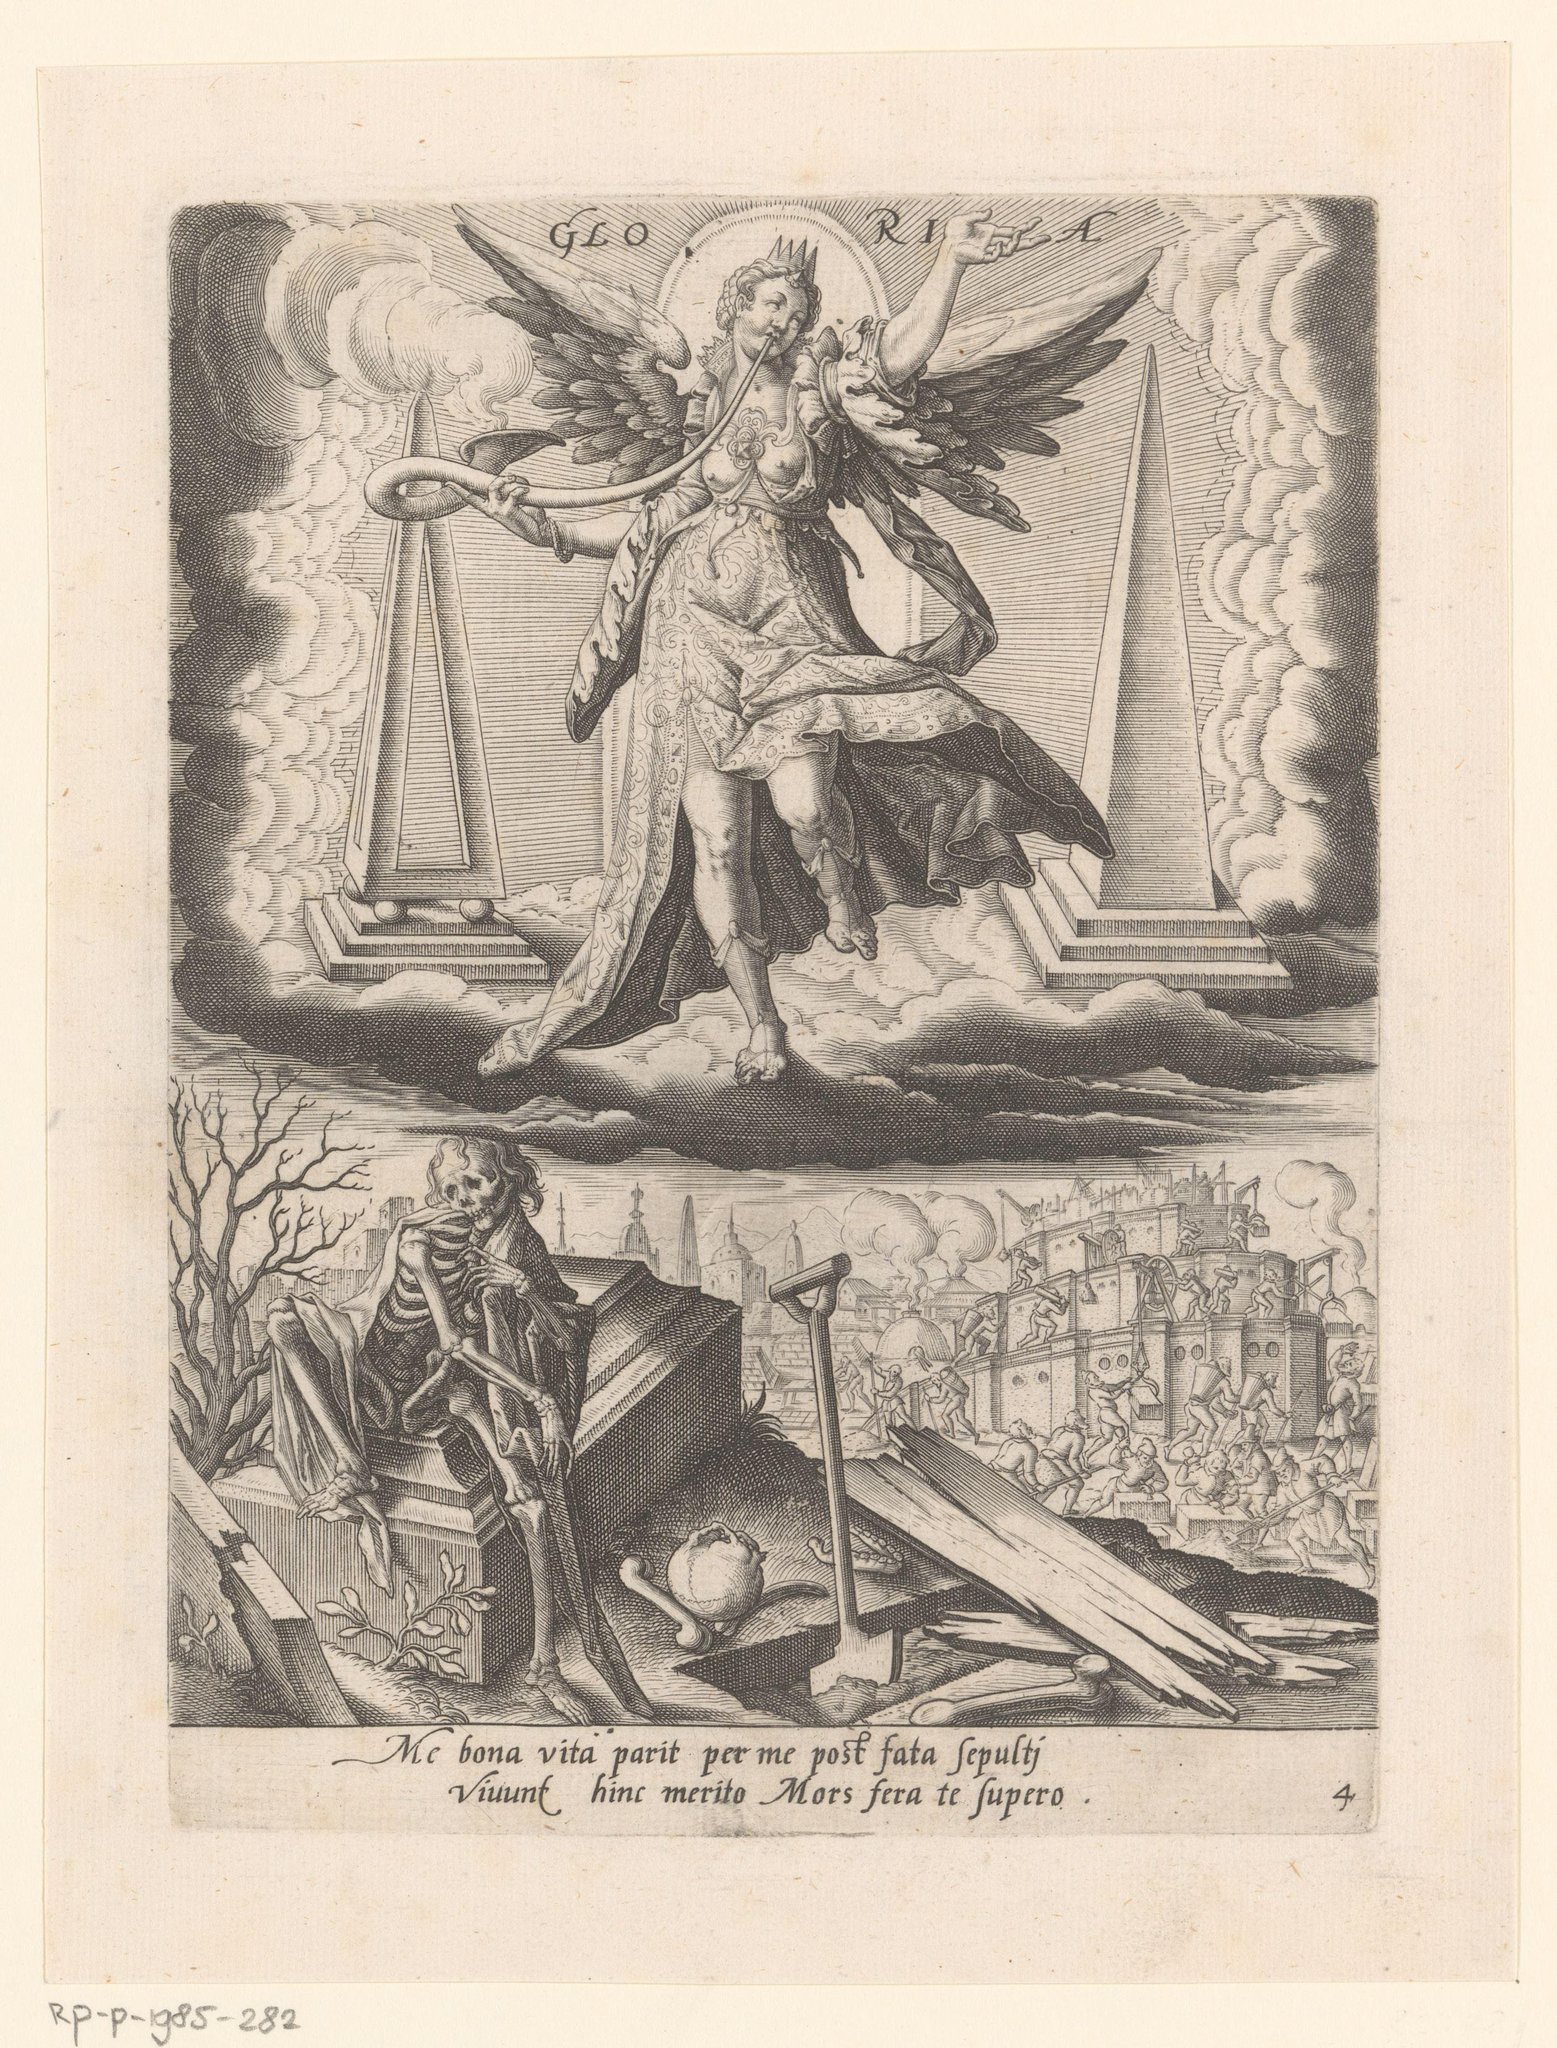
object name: print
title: Zes triomfen van Petrarca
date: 1596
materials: paper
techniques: engraving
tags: resurrection; 'ressurrettione' (ripa), 'trionfo della fama', 'triumphus famae'; 'carro della fama' (ripa), horn, trumpet, cornet, trombone, tuba, death as skeleton, the tower of babel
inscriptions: collector's mark: Lugt 2228, collector's mark: Lugt 2760